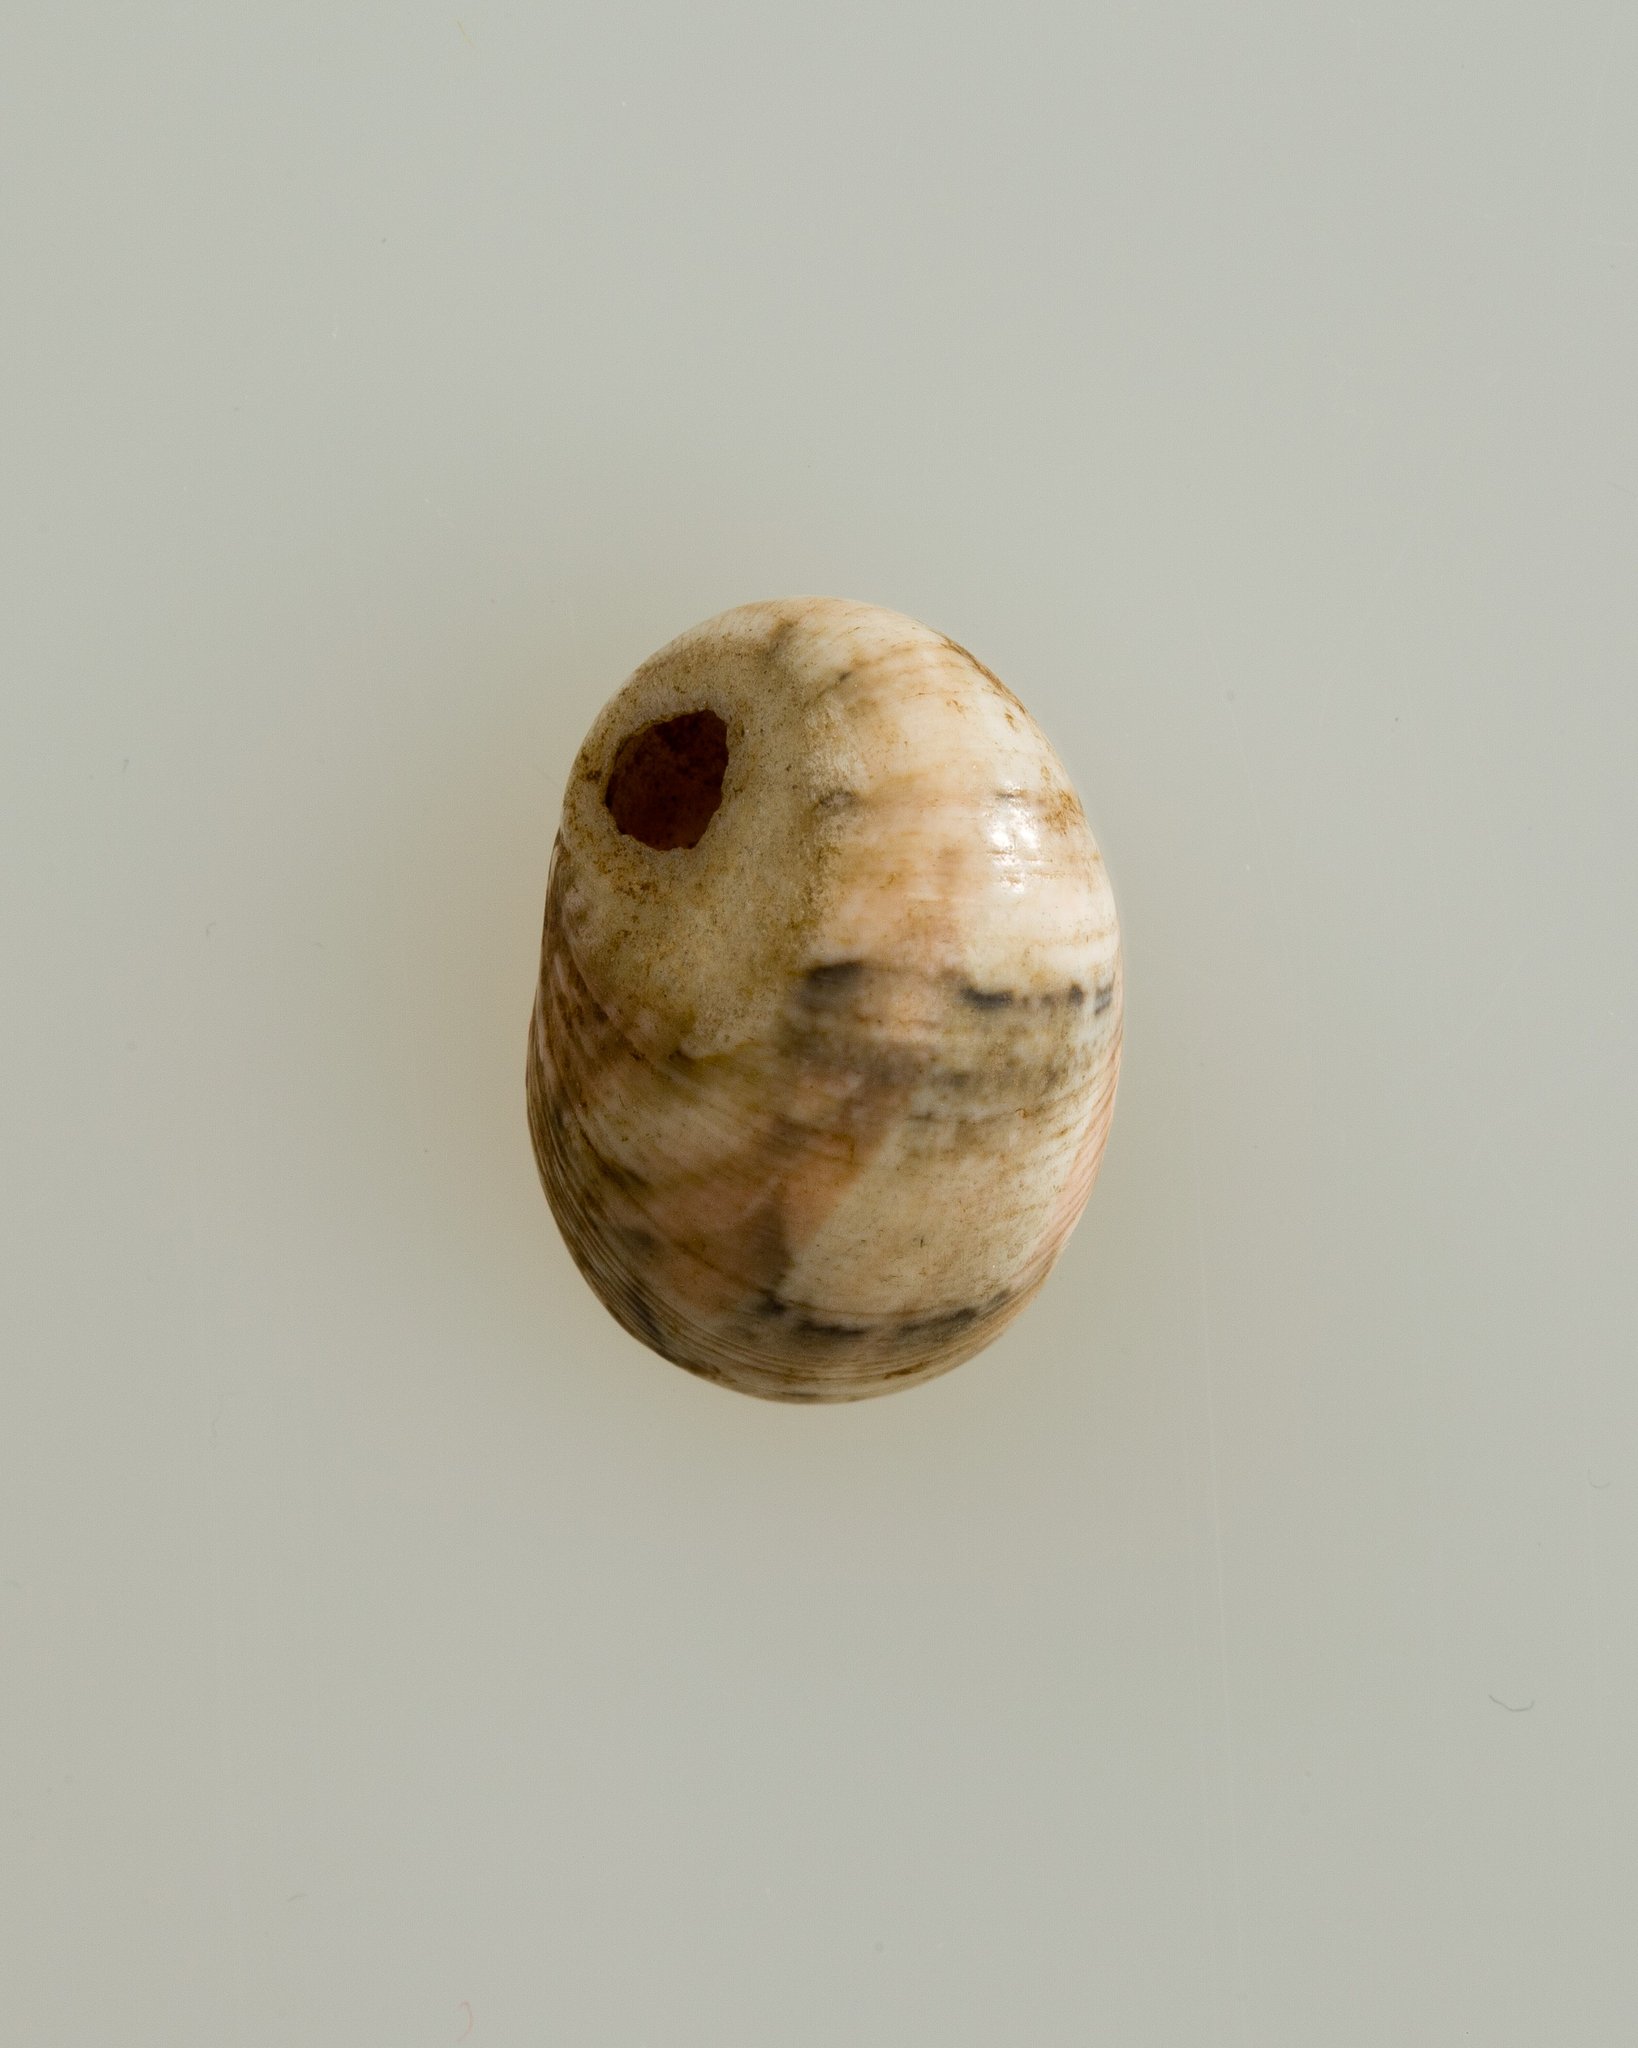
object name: pendant, shell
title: Shell pendant or bead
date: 3850-2960 BCE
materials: shell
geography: egypt